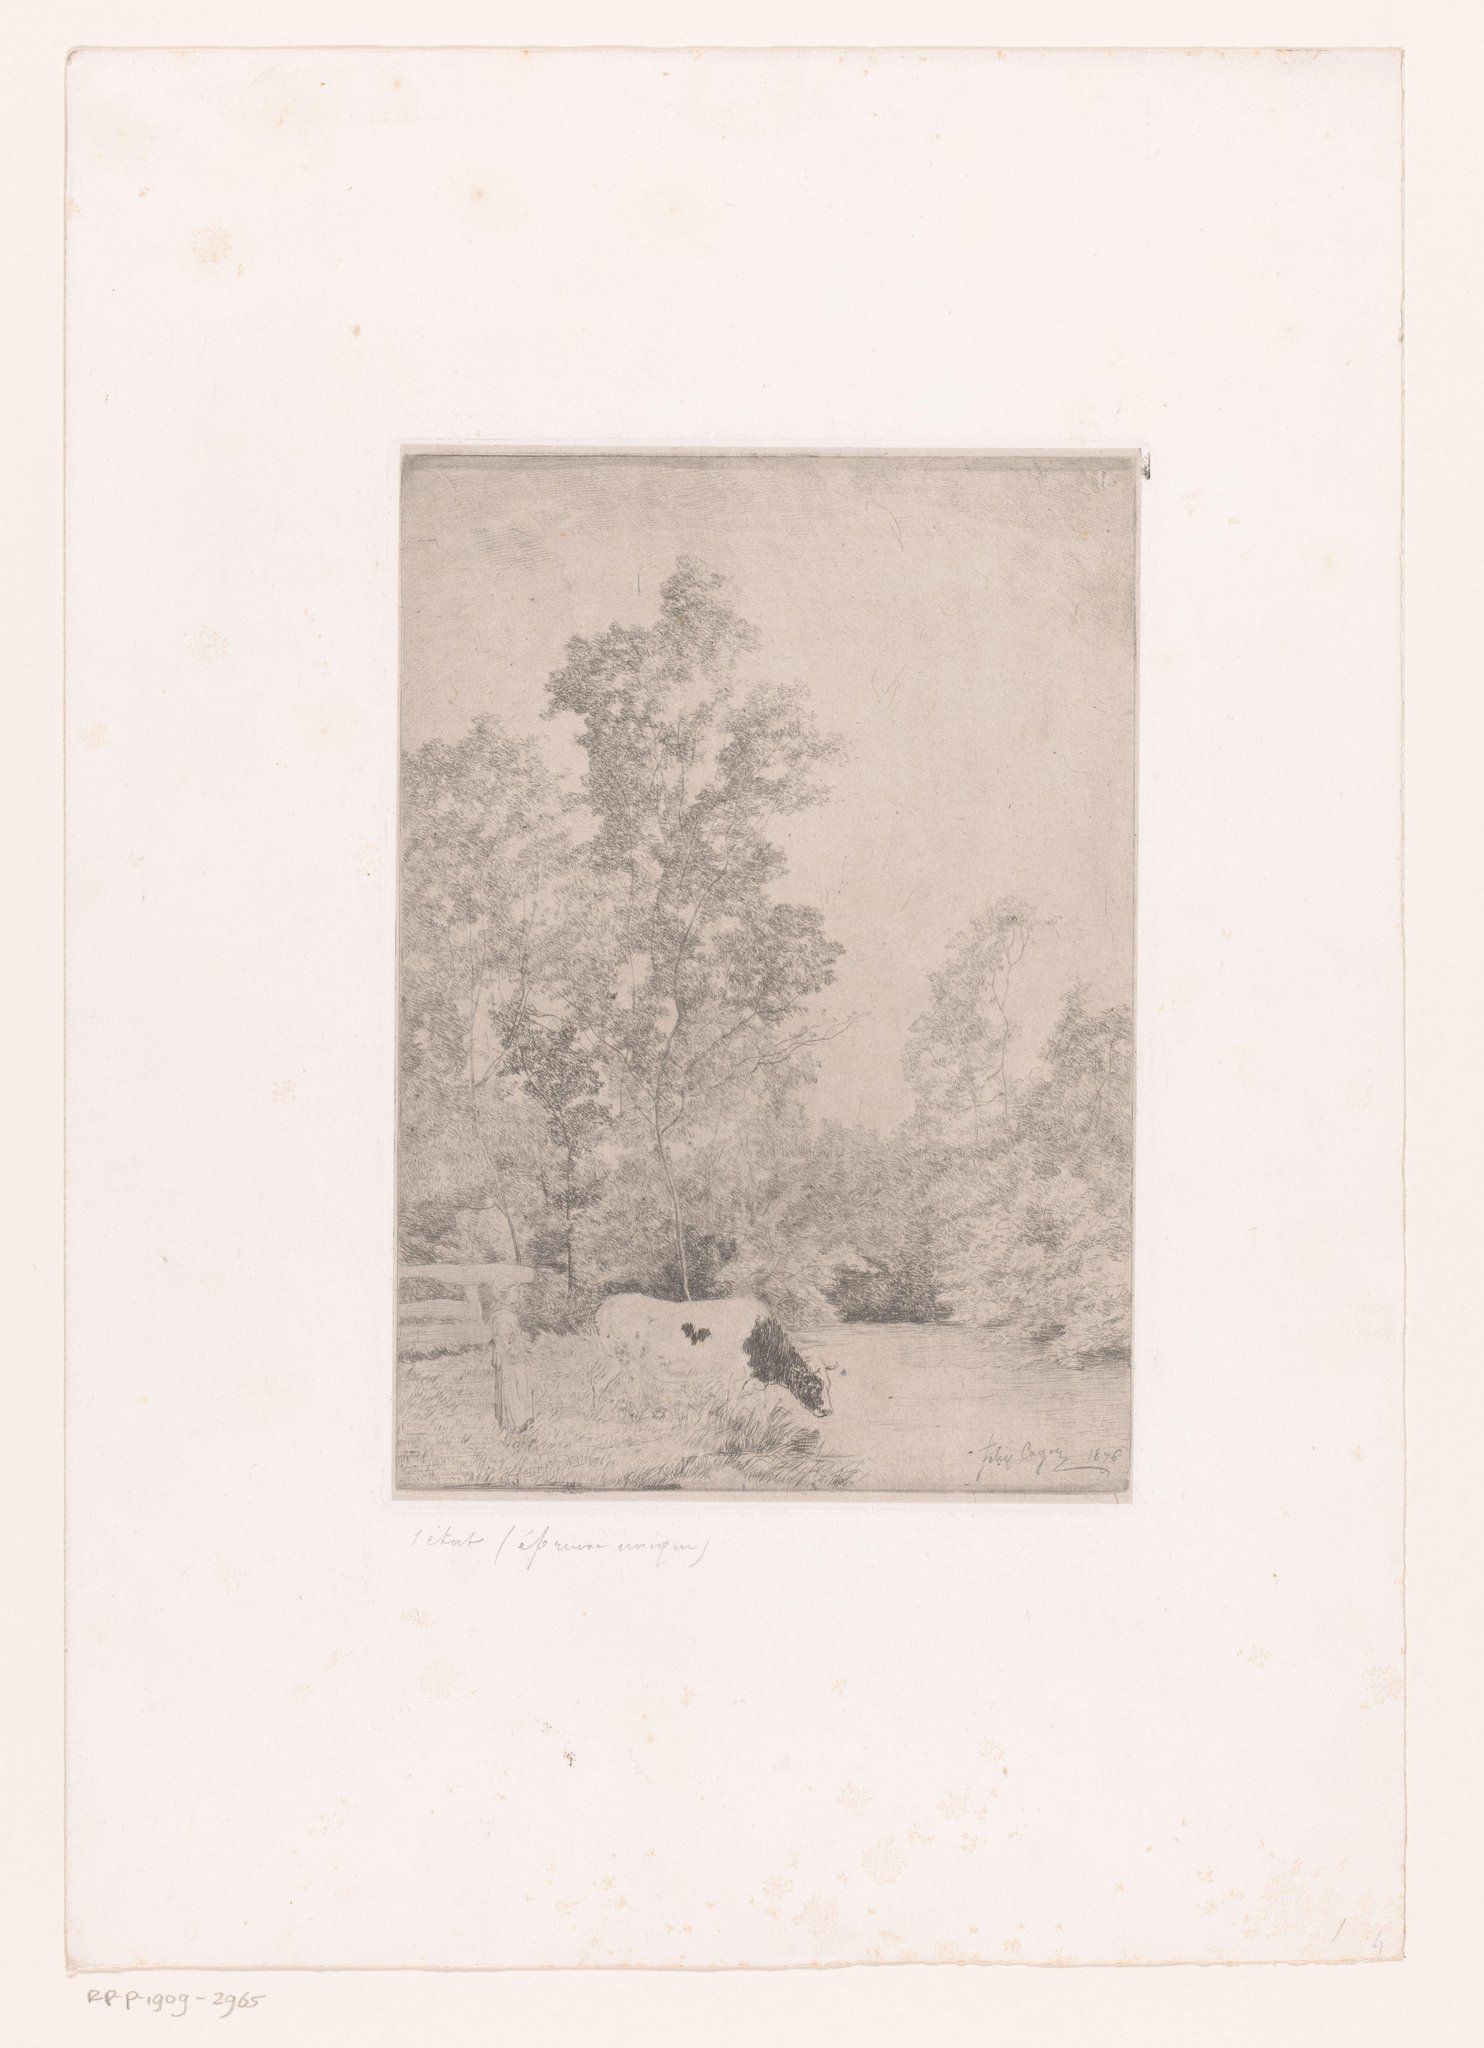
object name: print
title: Drinkende koe langs de oever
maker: félix cogen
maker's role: print maker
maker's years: 1838-1907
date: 1876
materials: paper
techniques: etching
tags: cow, river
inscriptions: inscription: ‘1 etat (épreuve unique)’, collector's mark